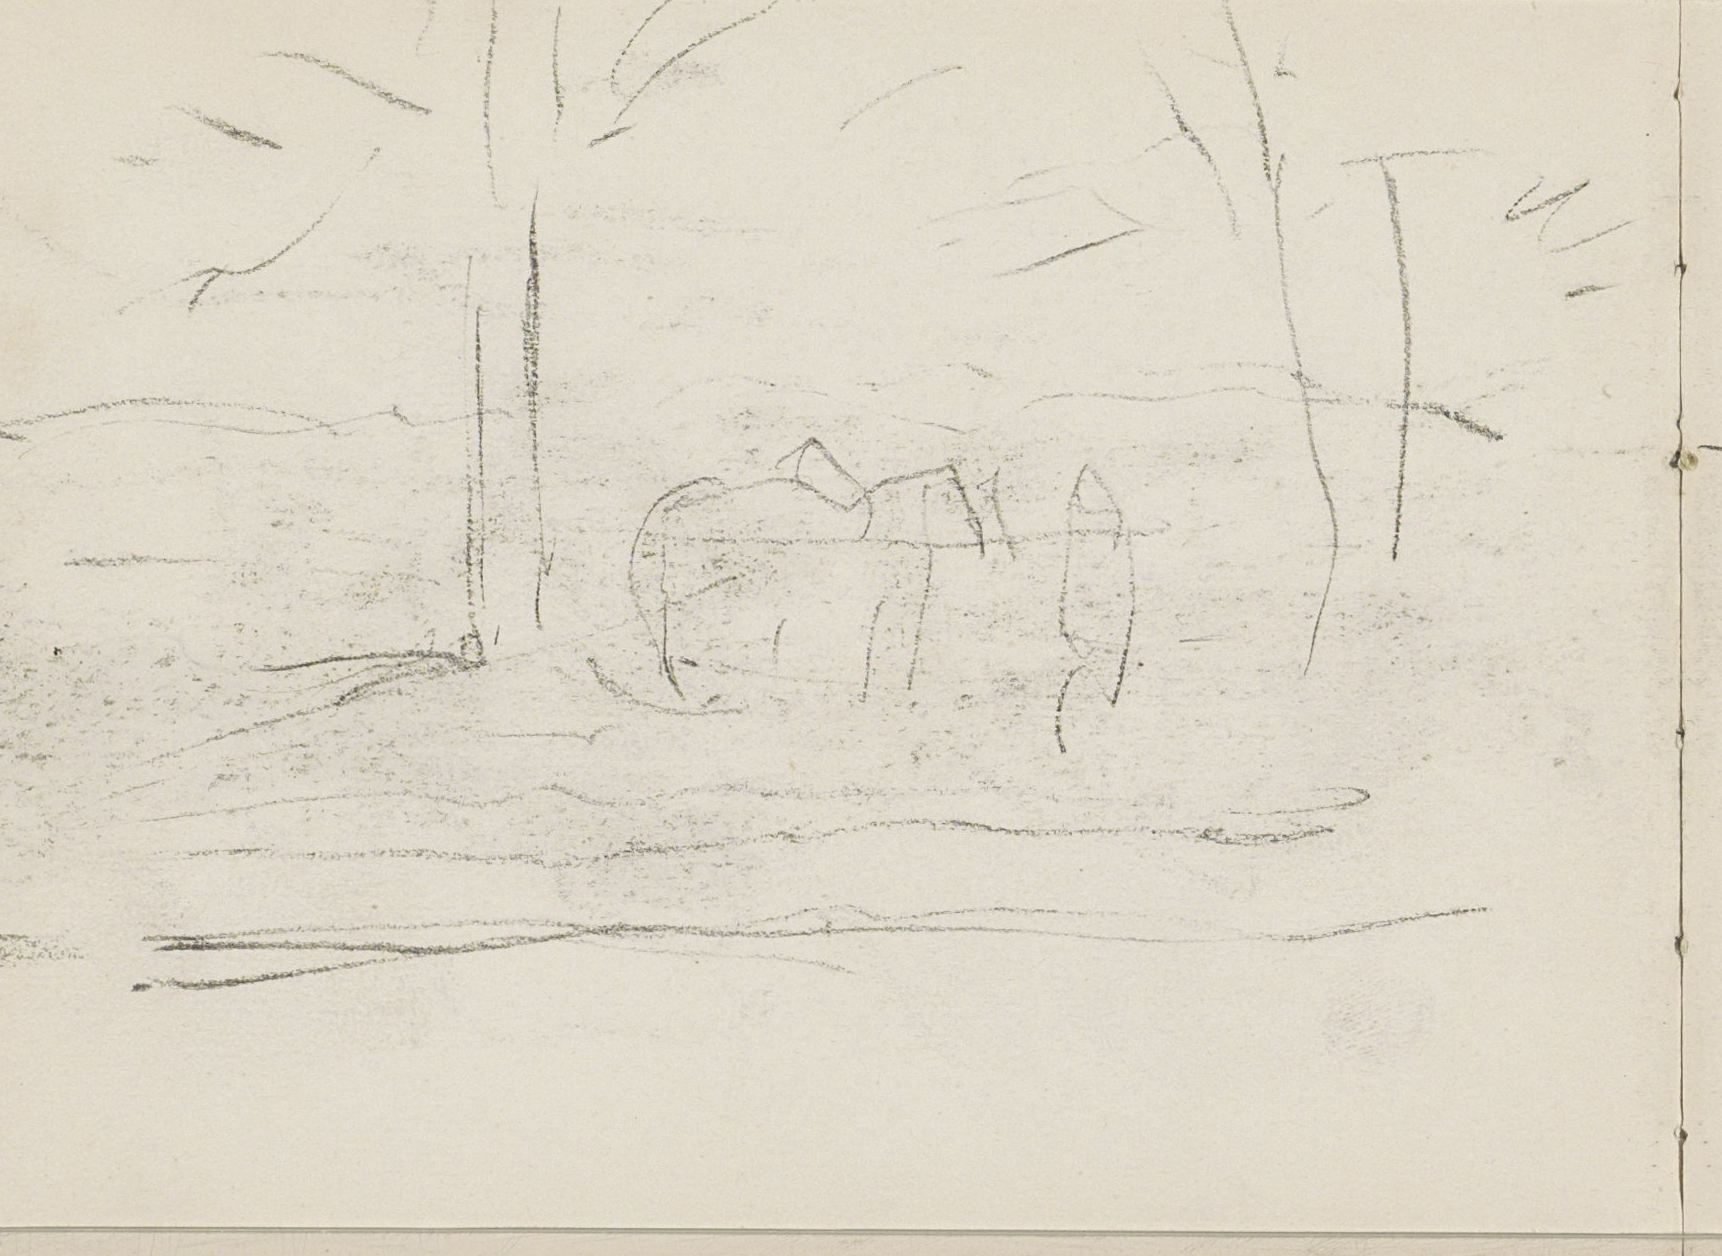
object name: sketchbook leaf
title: Dier tussen twee bomen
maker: anton mauve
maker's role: draughtsman, painter, print maker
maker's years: 1838-1888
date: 1848-1888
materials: chalk, paper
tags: trees, animals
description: Blad 19 verso uit een schetsboek met 33 bladen.